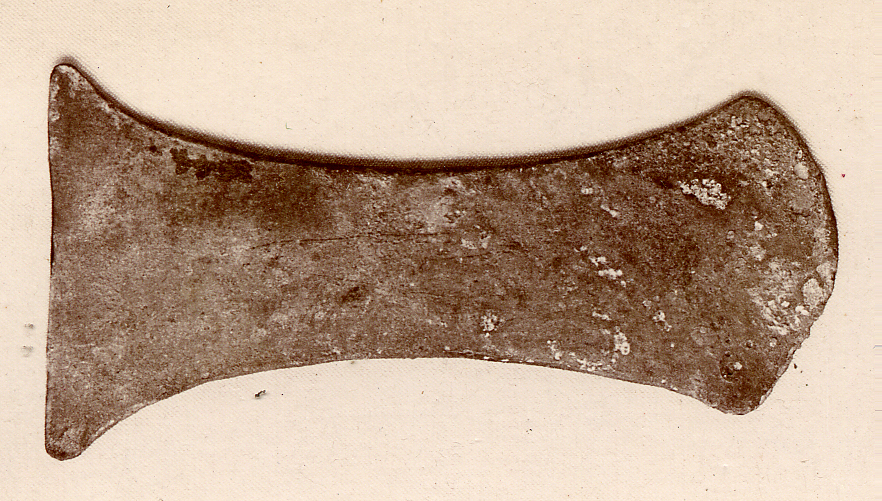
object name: model ax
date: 1640-1550 BCE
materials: bronze, copper alloy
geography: egypt